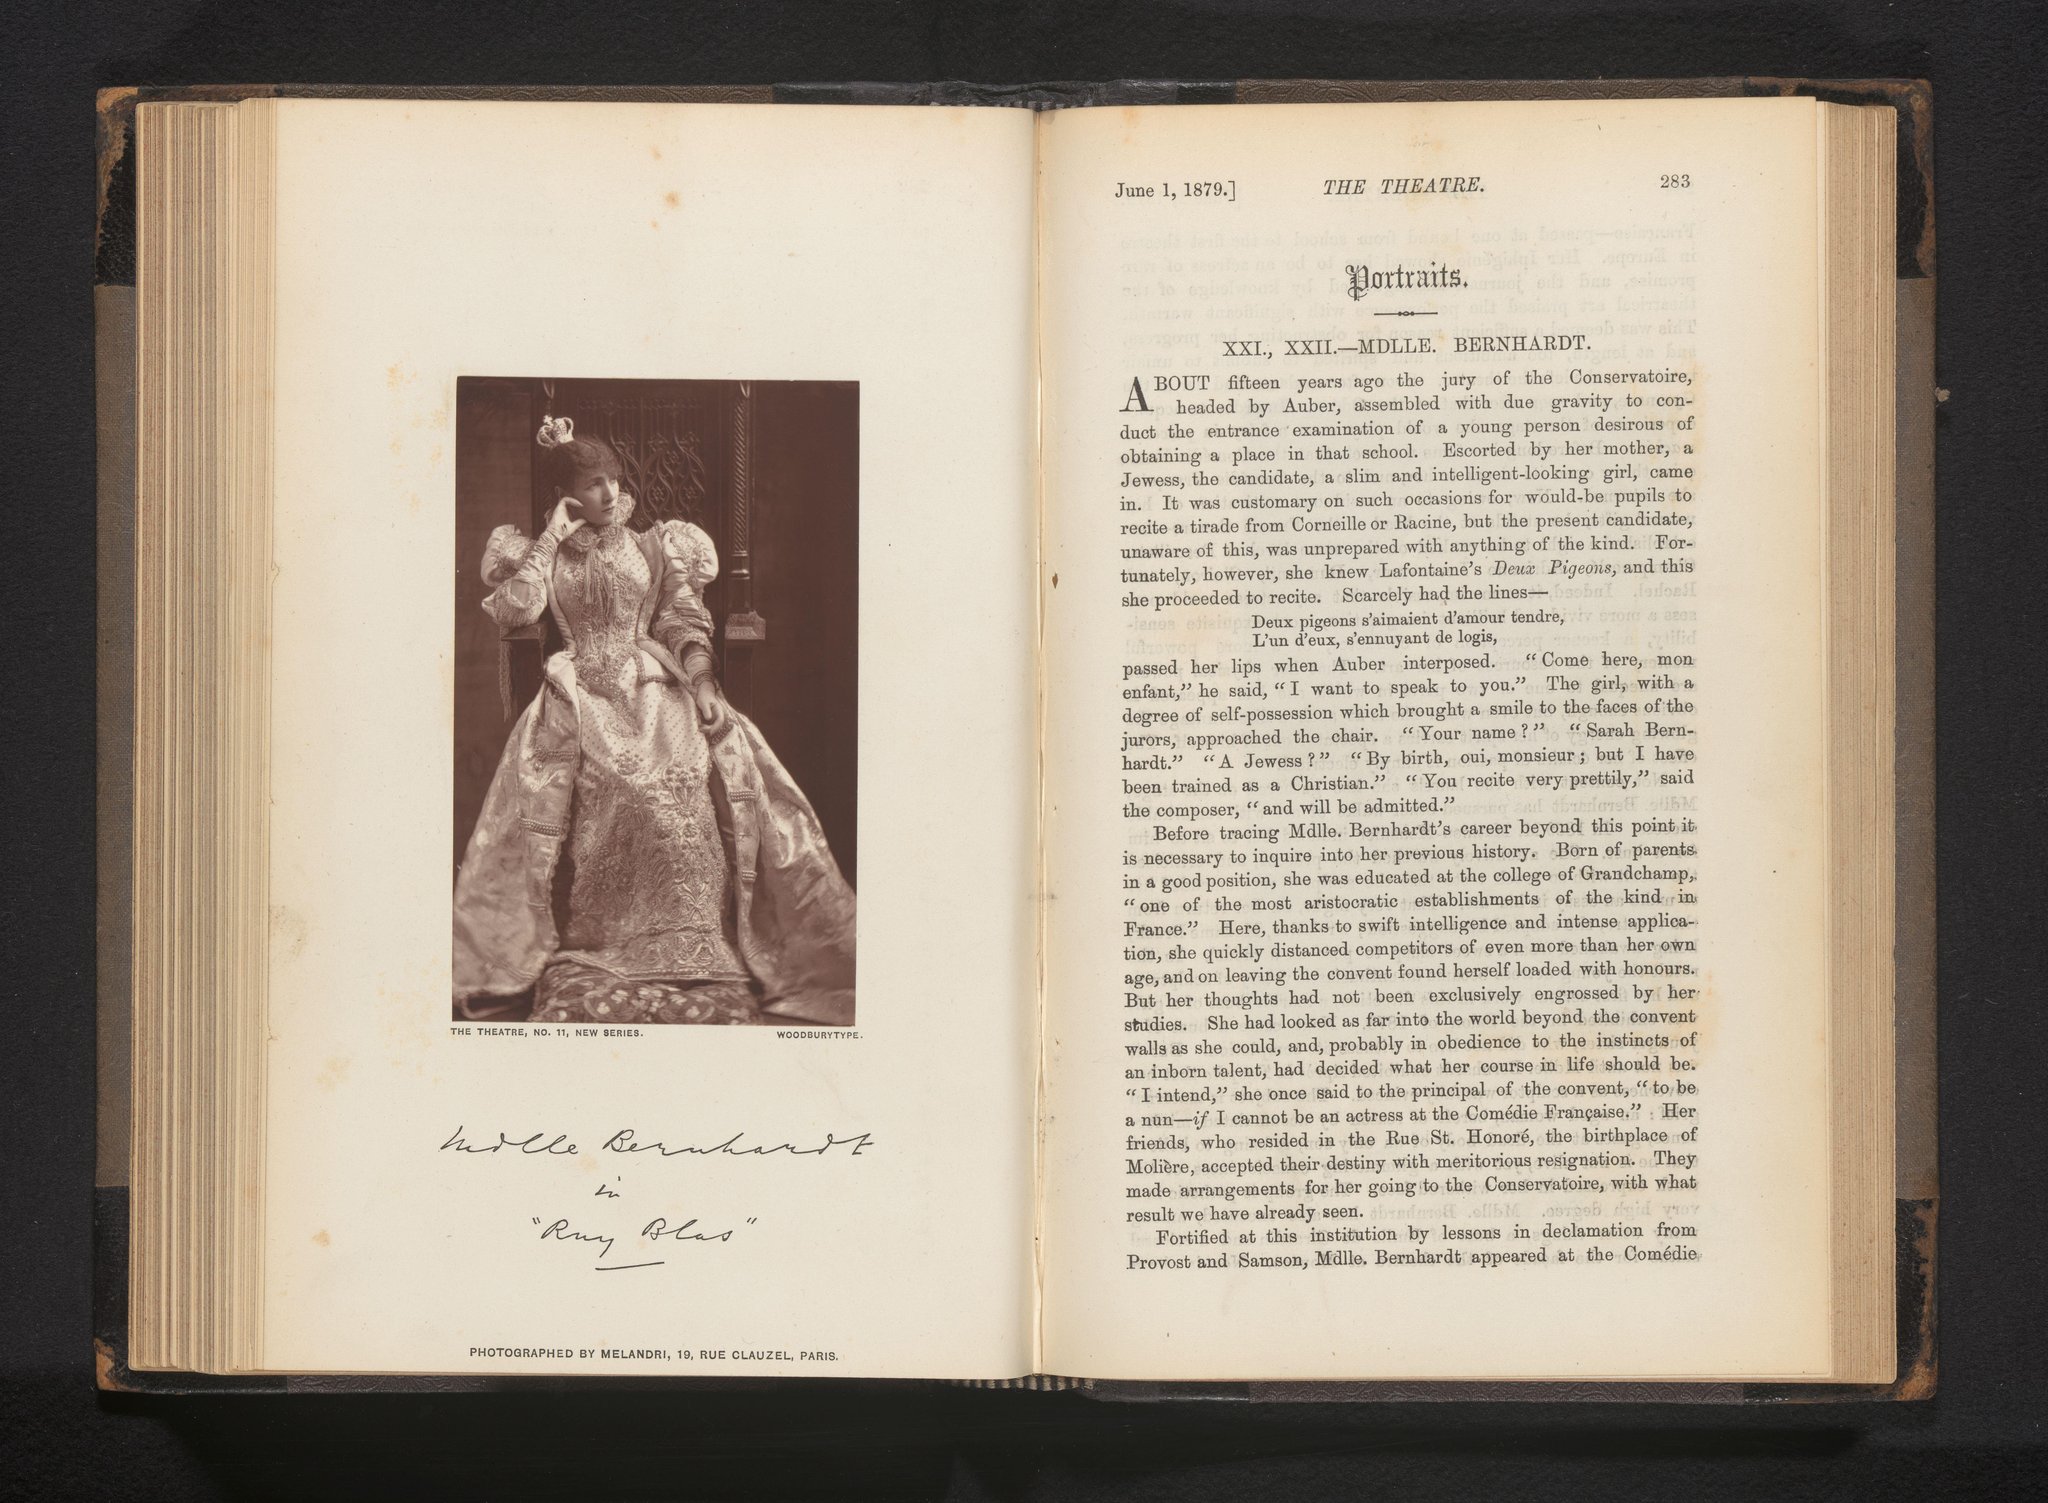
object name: photomechanical print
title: Portret van Sarah Bernhardt in kostuum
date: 1874-1879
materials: paper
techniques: woodburytype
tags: paris, sculptor, sarah bernhardt, adult woman, historical persons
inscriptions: signature: ‘Srarah Bernhardt/ in/ Ruy Blas’